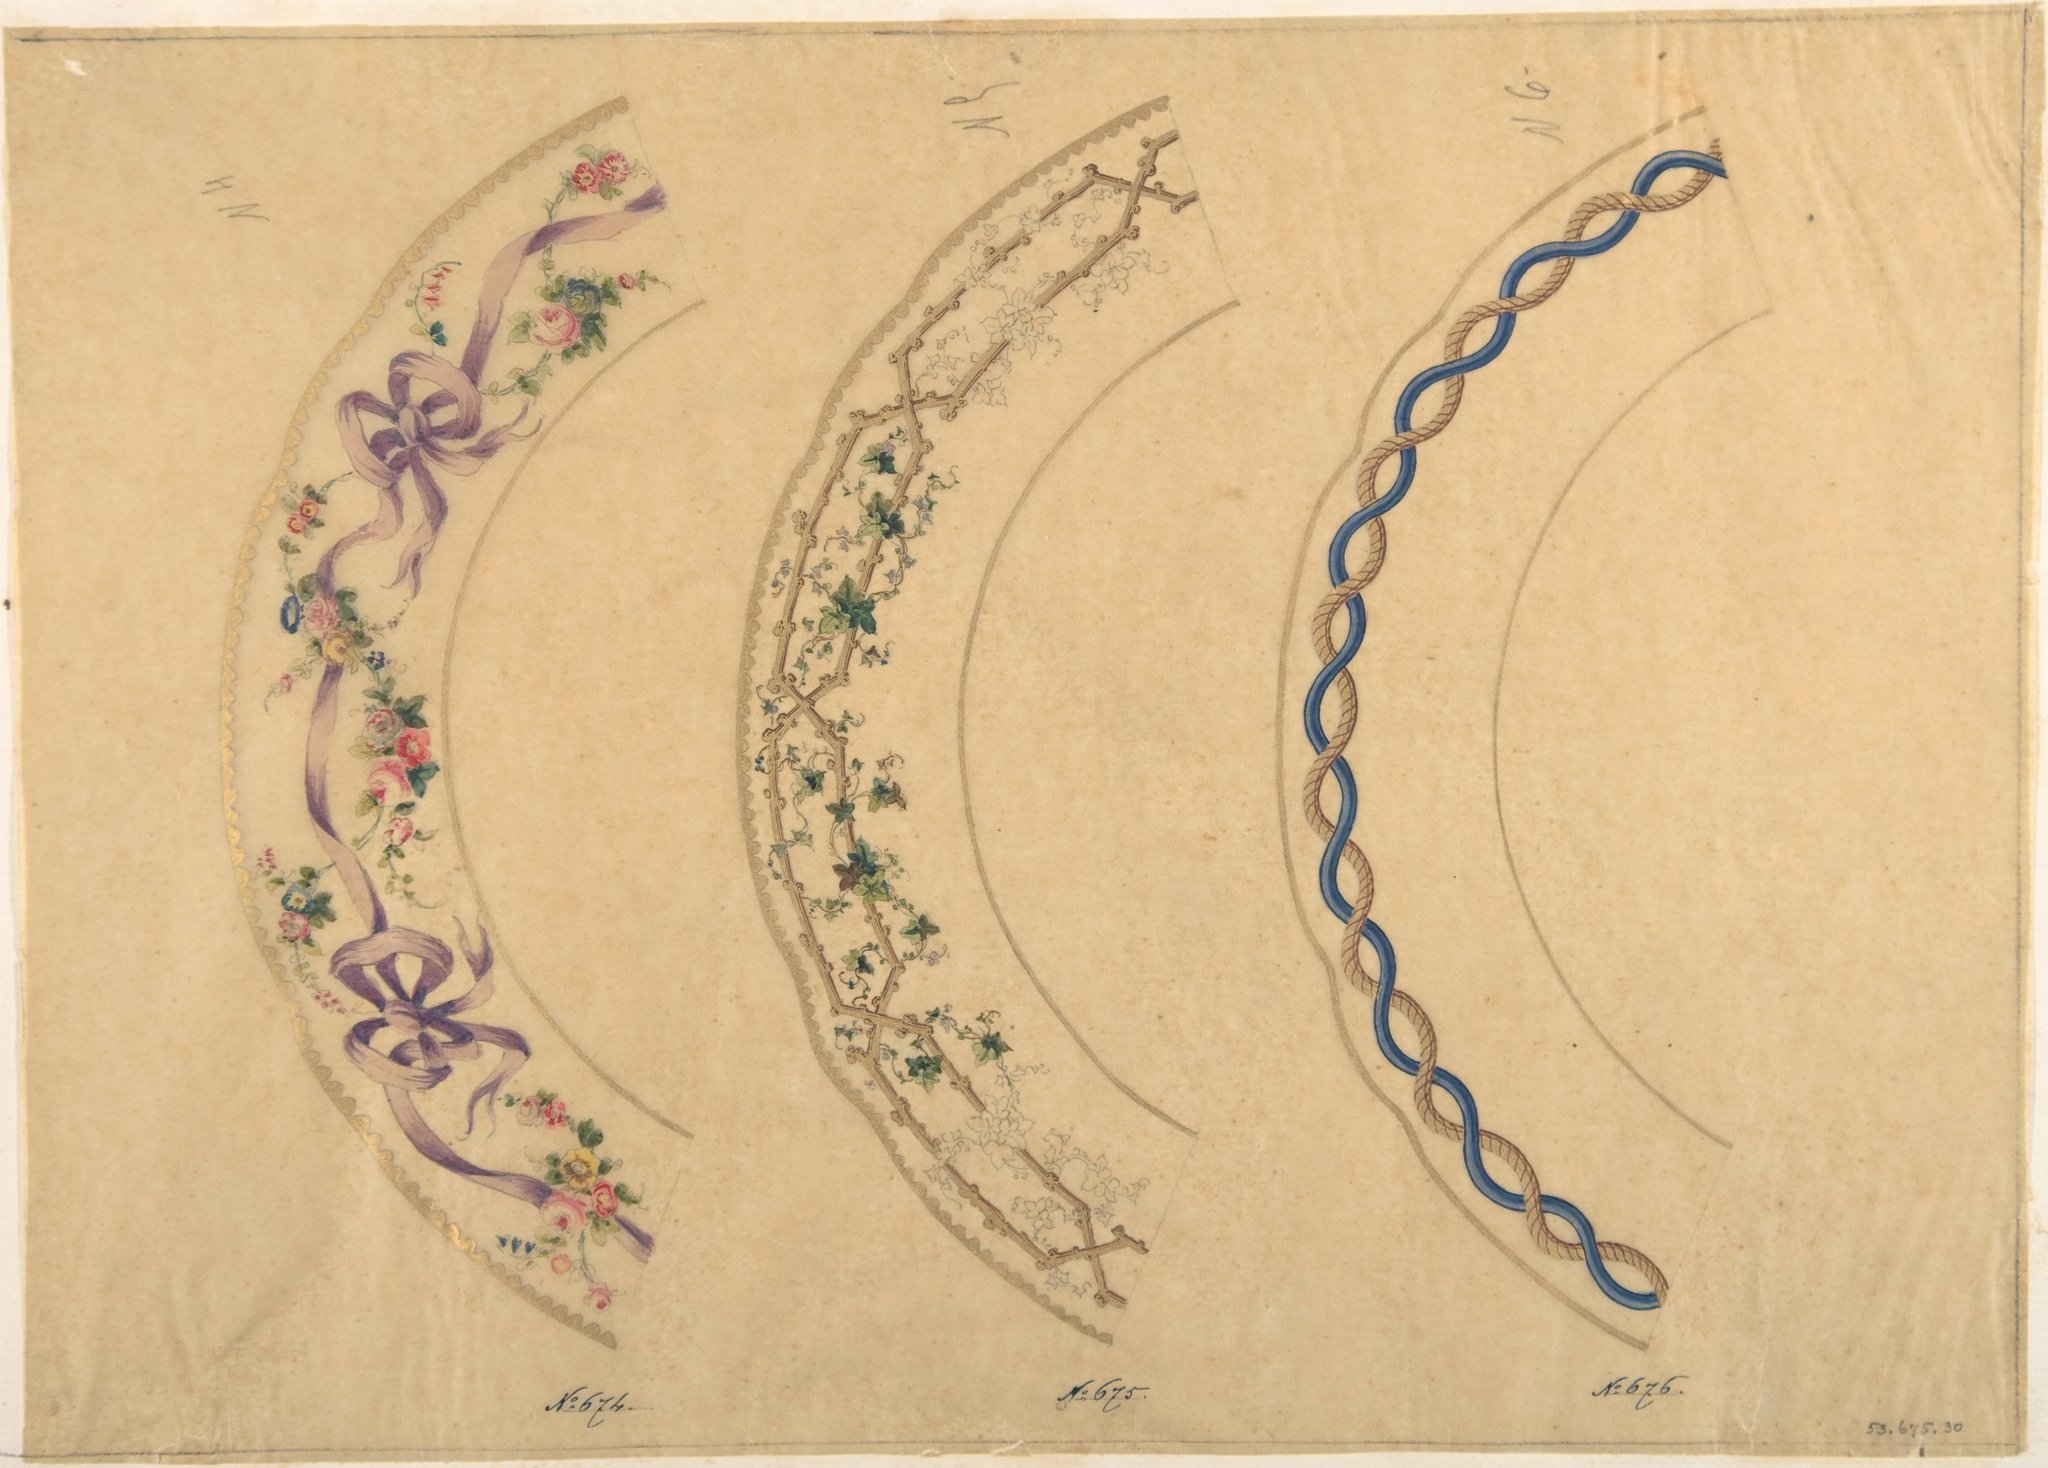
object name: drawing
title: Three Designs for Plate Borders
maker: anonymous, french, 19th century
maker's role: artist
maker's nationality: french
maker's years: 1800-1900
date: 1801-1900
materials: gold paint, graphite, watercolor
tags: flowers,leaves